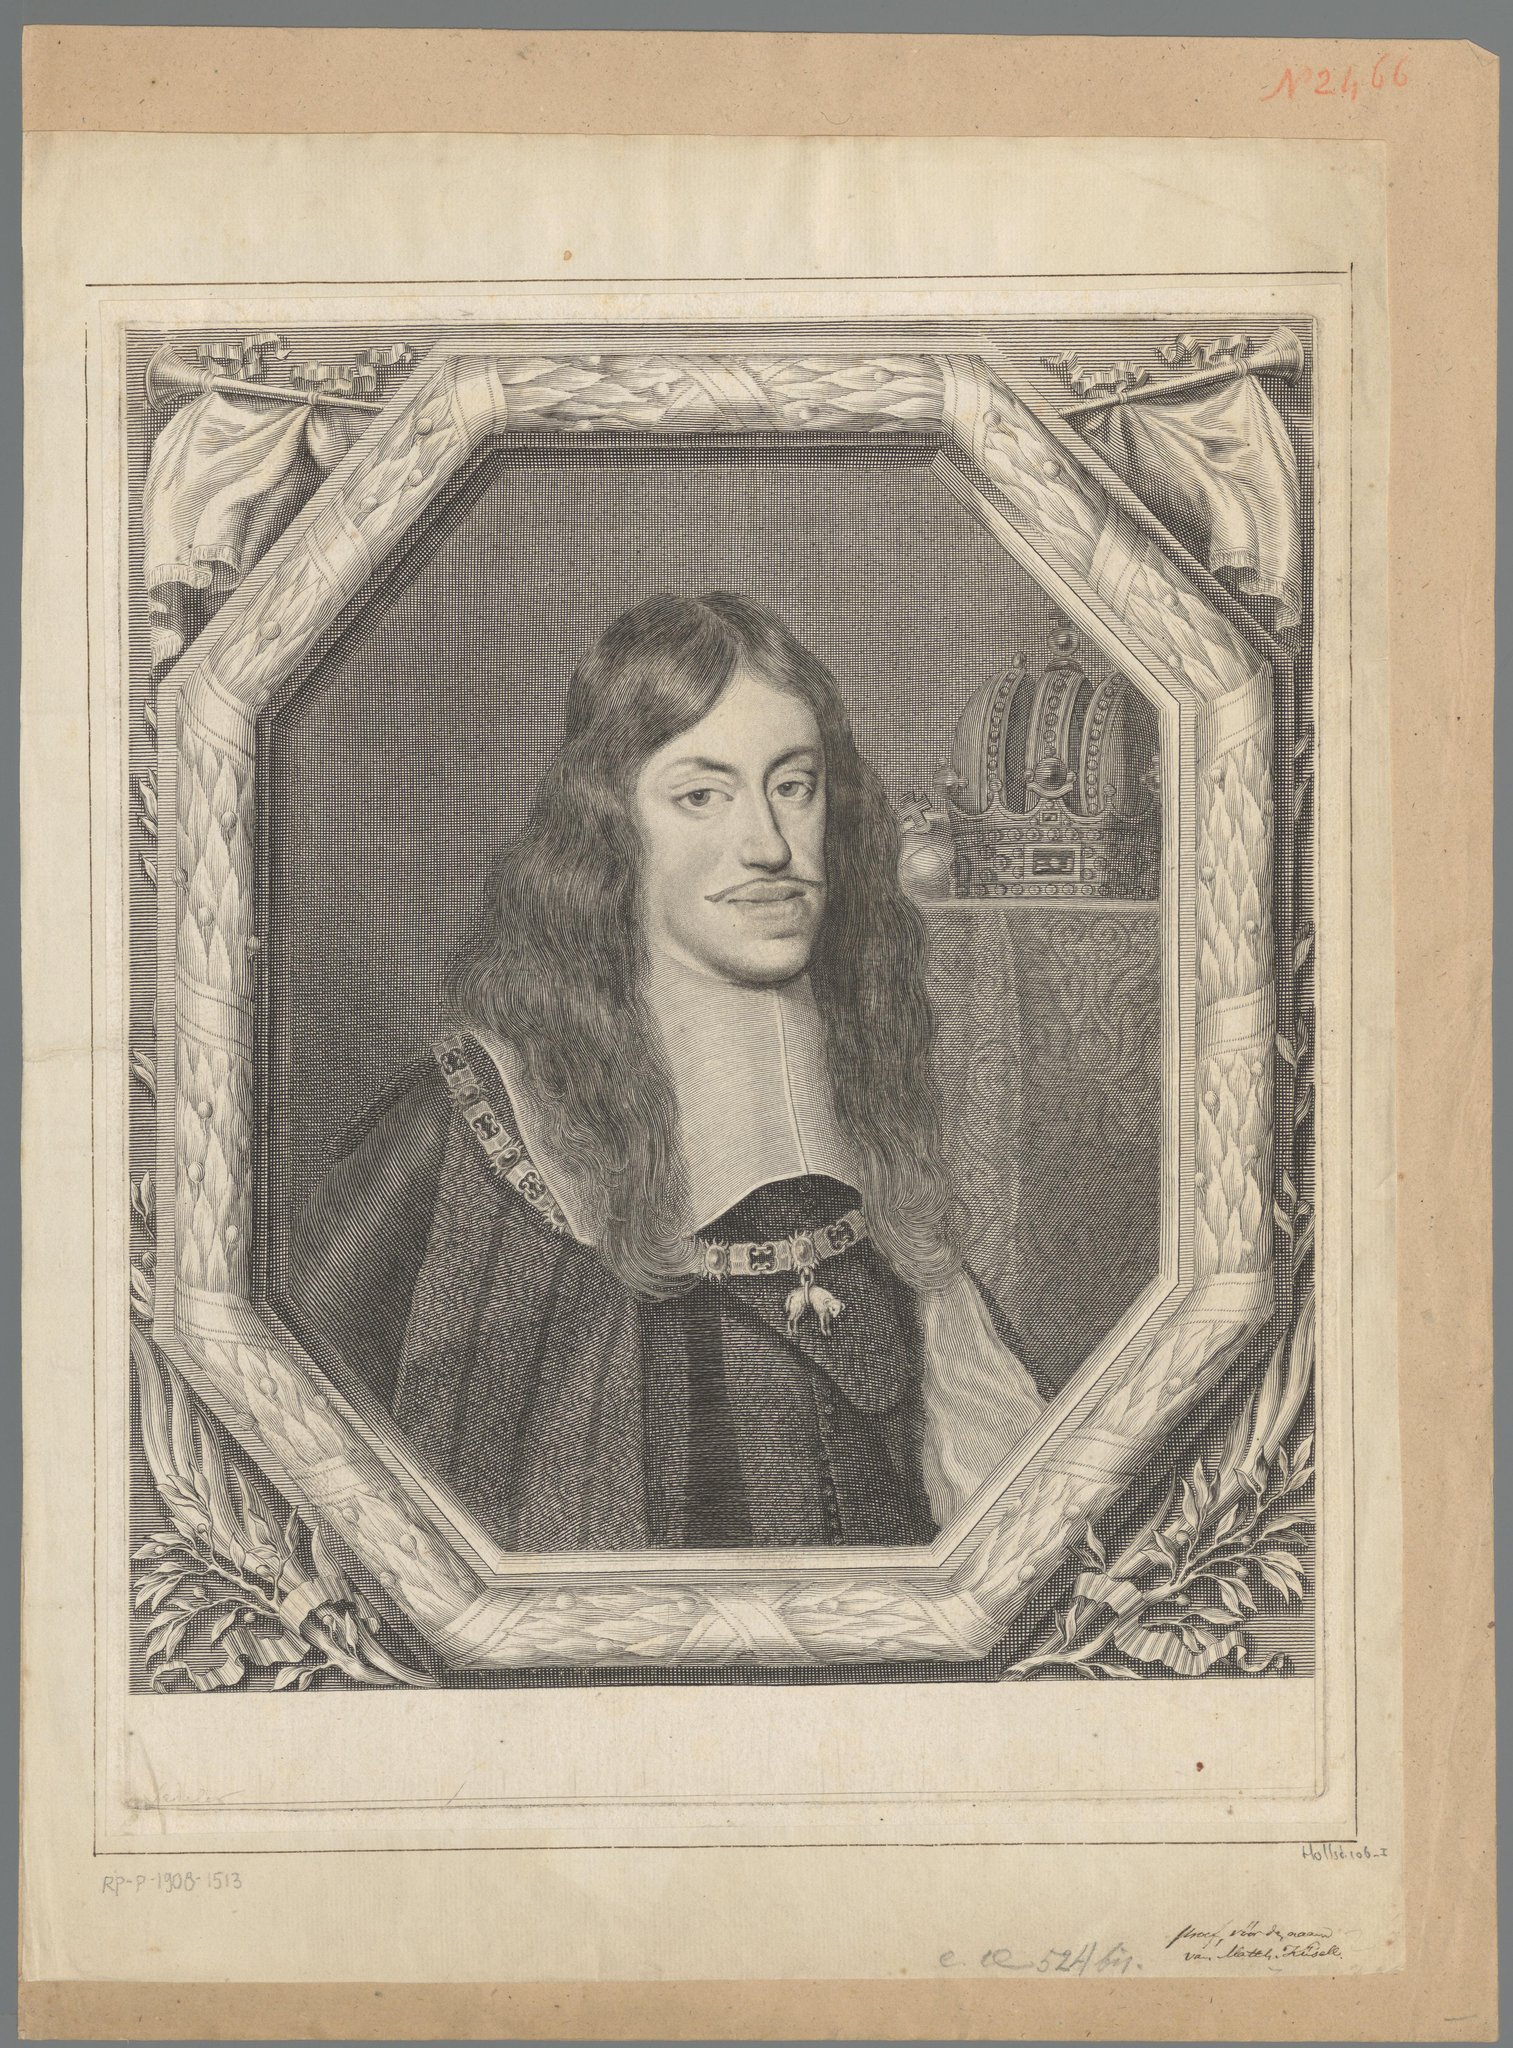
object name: print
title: Portret van keizer Leopold I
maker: mathäus küsel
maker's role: print maker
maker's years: 1629-1681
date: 1658-1681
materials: paper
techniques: engraving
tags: leopold i (keizer van duitsland), historical persons, ruler, sovereign, knighthood order of the golden fleece - insignia of a knighthood order, e.g.: badge, chain (with name of order), insignia and symbols of sovereignty (crown, diadem, sceptre, orb, seal, standard, cloak, pectoral)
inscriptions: collector's mark: Lugt 2228